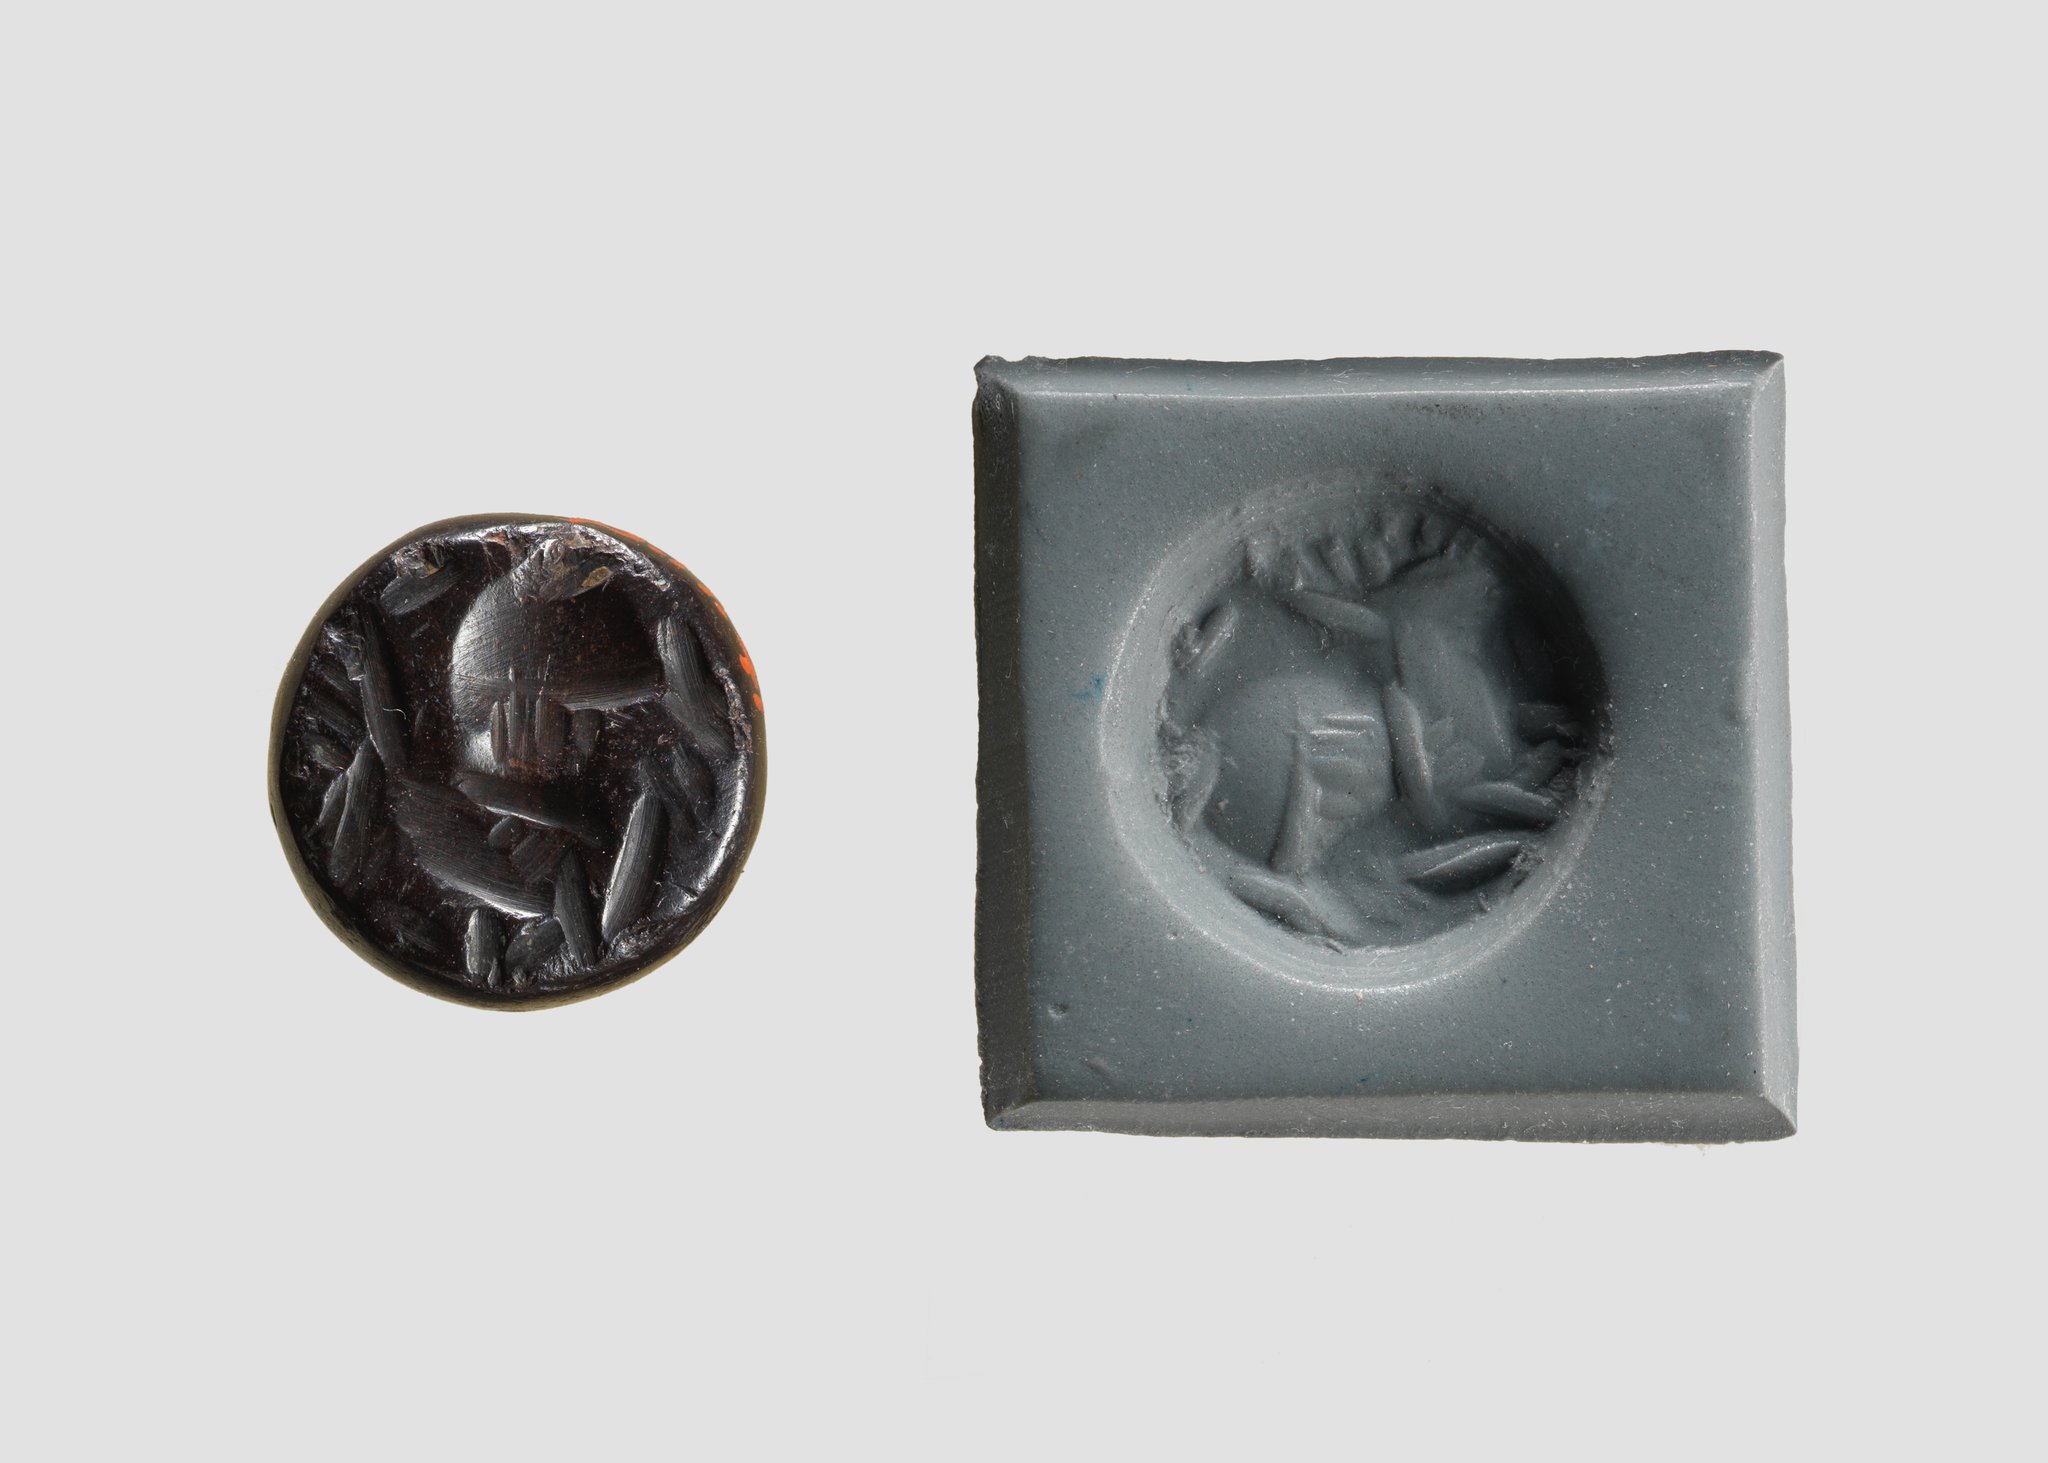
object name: stamp seal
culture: sasanian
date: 201-700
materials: mineral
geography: iran or mesopotamia